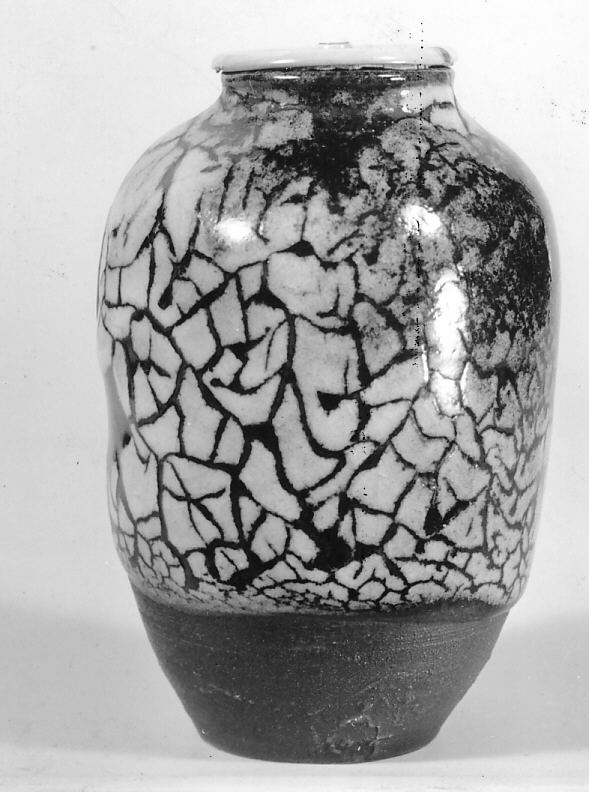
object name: tea jar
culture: japanese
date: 1801-1900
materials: clay, glaze